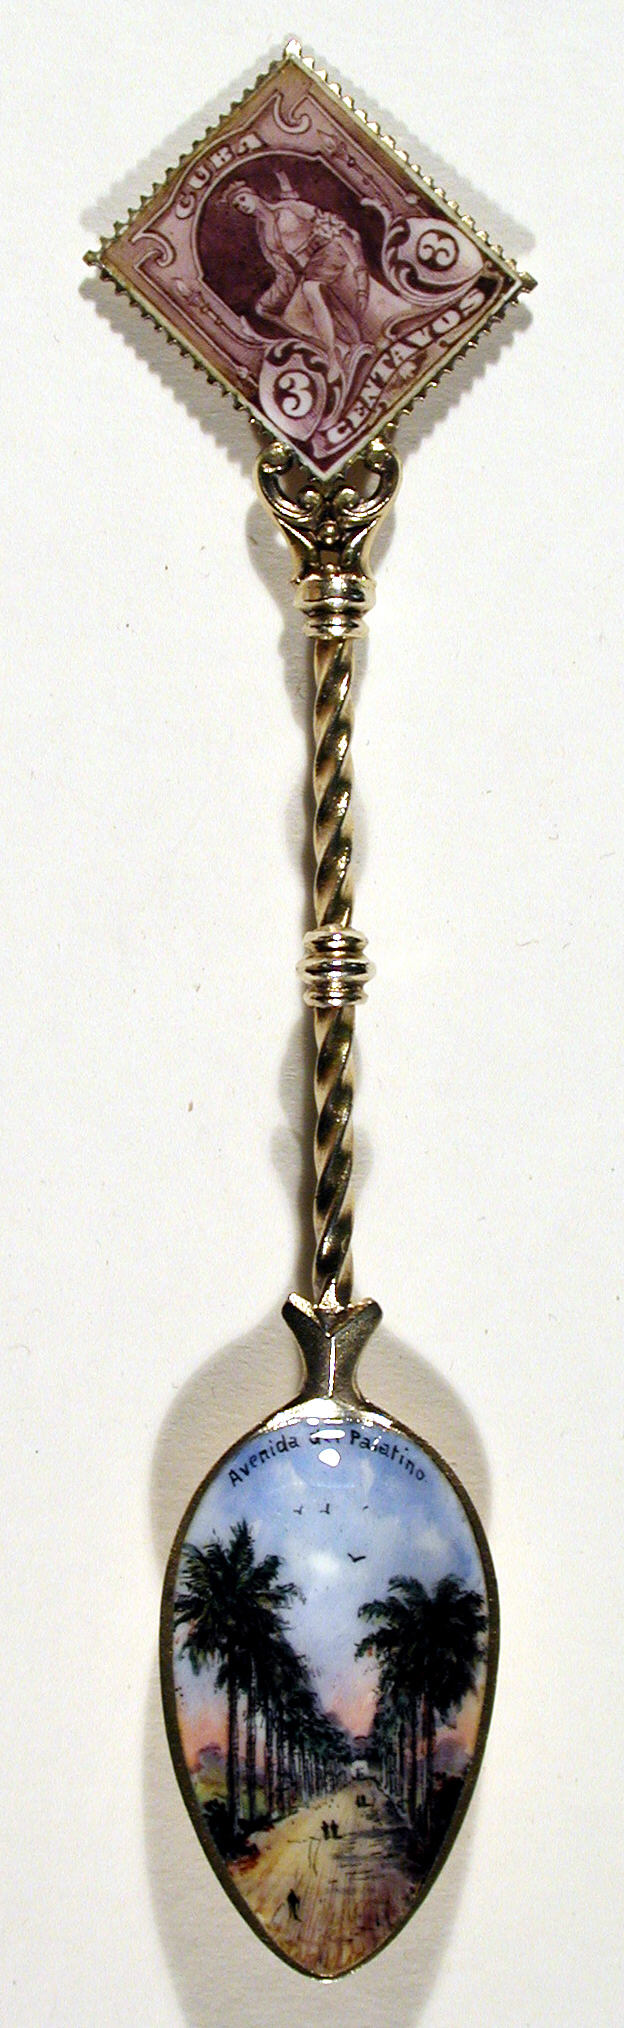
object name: souvenir spoon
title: Souvenir spoon with view of a long avenue and finial in the form of a postage stamp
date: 1867-1900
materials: enamel, gilt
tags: roads,trees